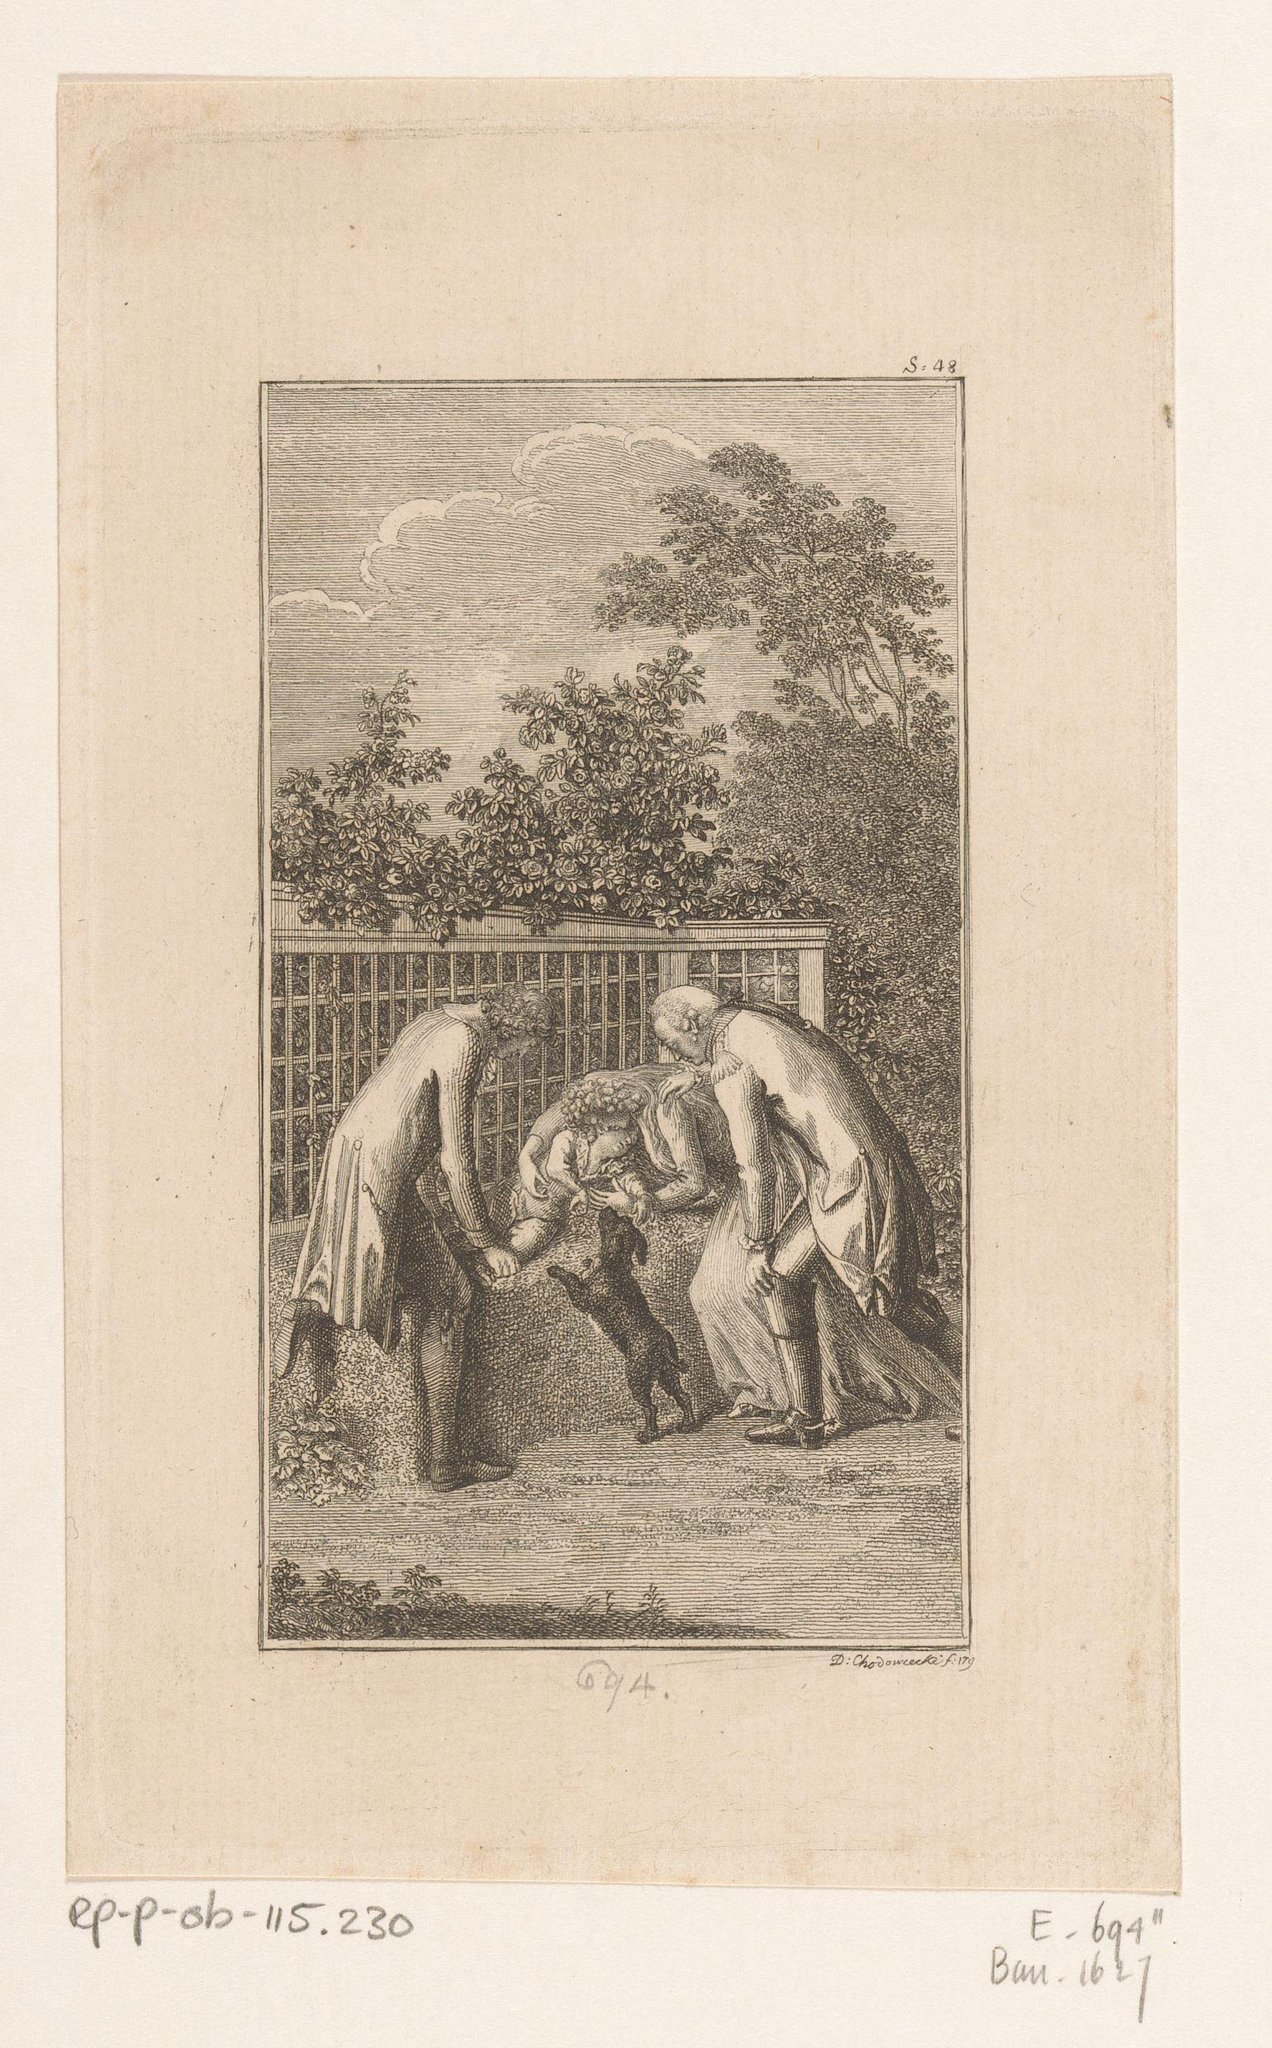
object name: print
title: Gustav slapend bij de rozenstruik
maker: daniel nikolaus chodowiecki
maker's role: draughtsman, print maker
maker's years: 1726-1801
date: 1792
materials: paper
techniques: etching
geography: berlin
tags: literature, shrubs: rose-bush, sleeping; unconsciousness, parental love, dog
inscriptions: collector's mark: Lugt 2228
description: Prent gebruikt voor: Richter, Friedrich. Die unsichtbare Loge. Eine Biographie von Jean Paul. 2 dln. Berlijn: Karl Matzdorffs Buchhandlung, 1793.